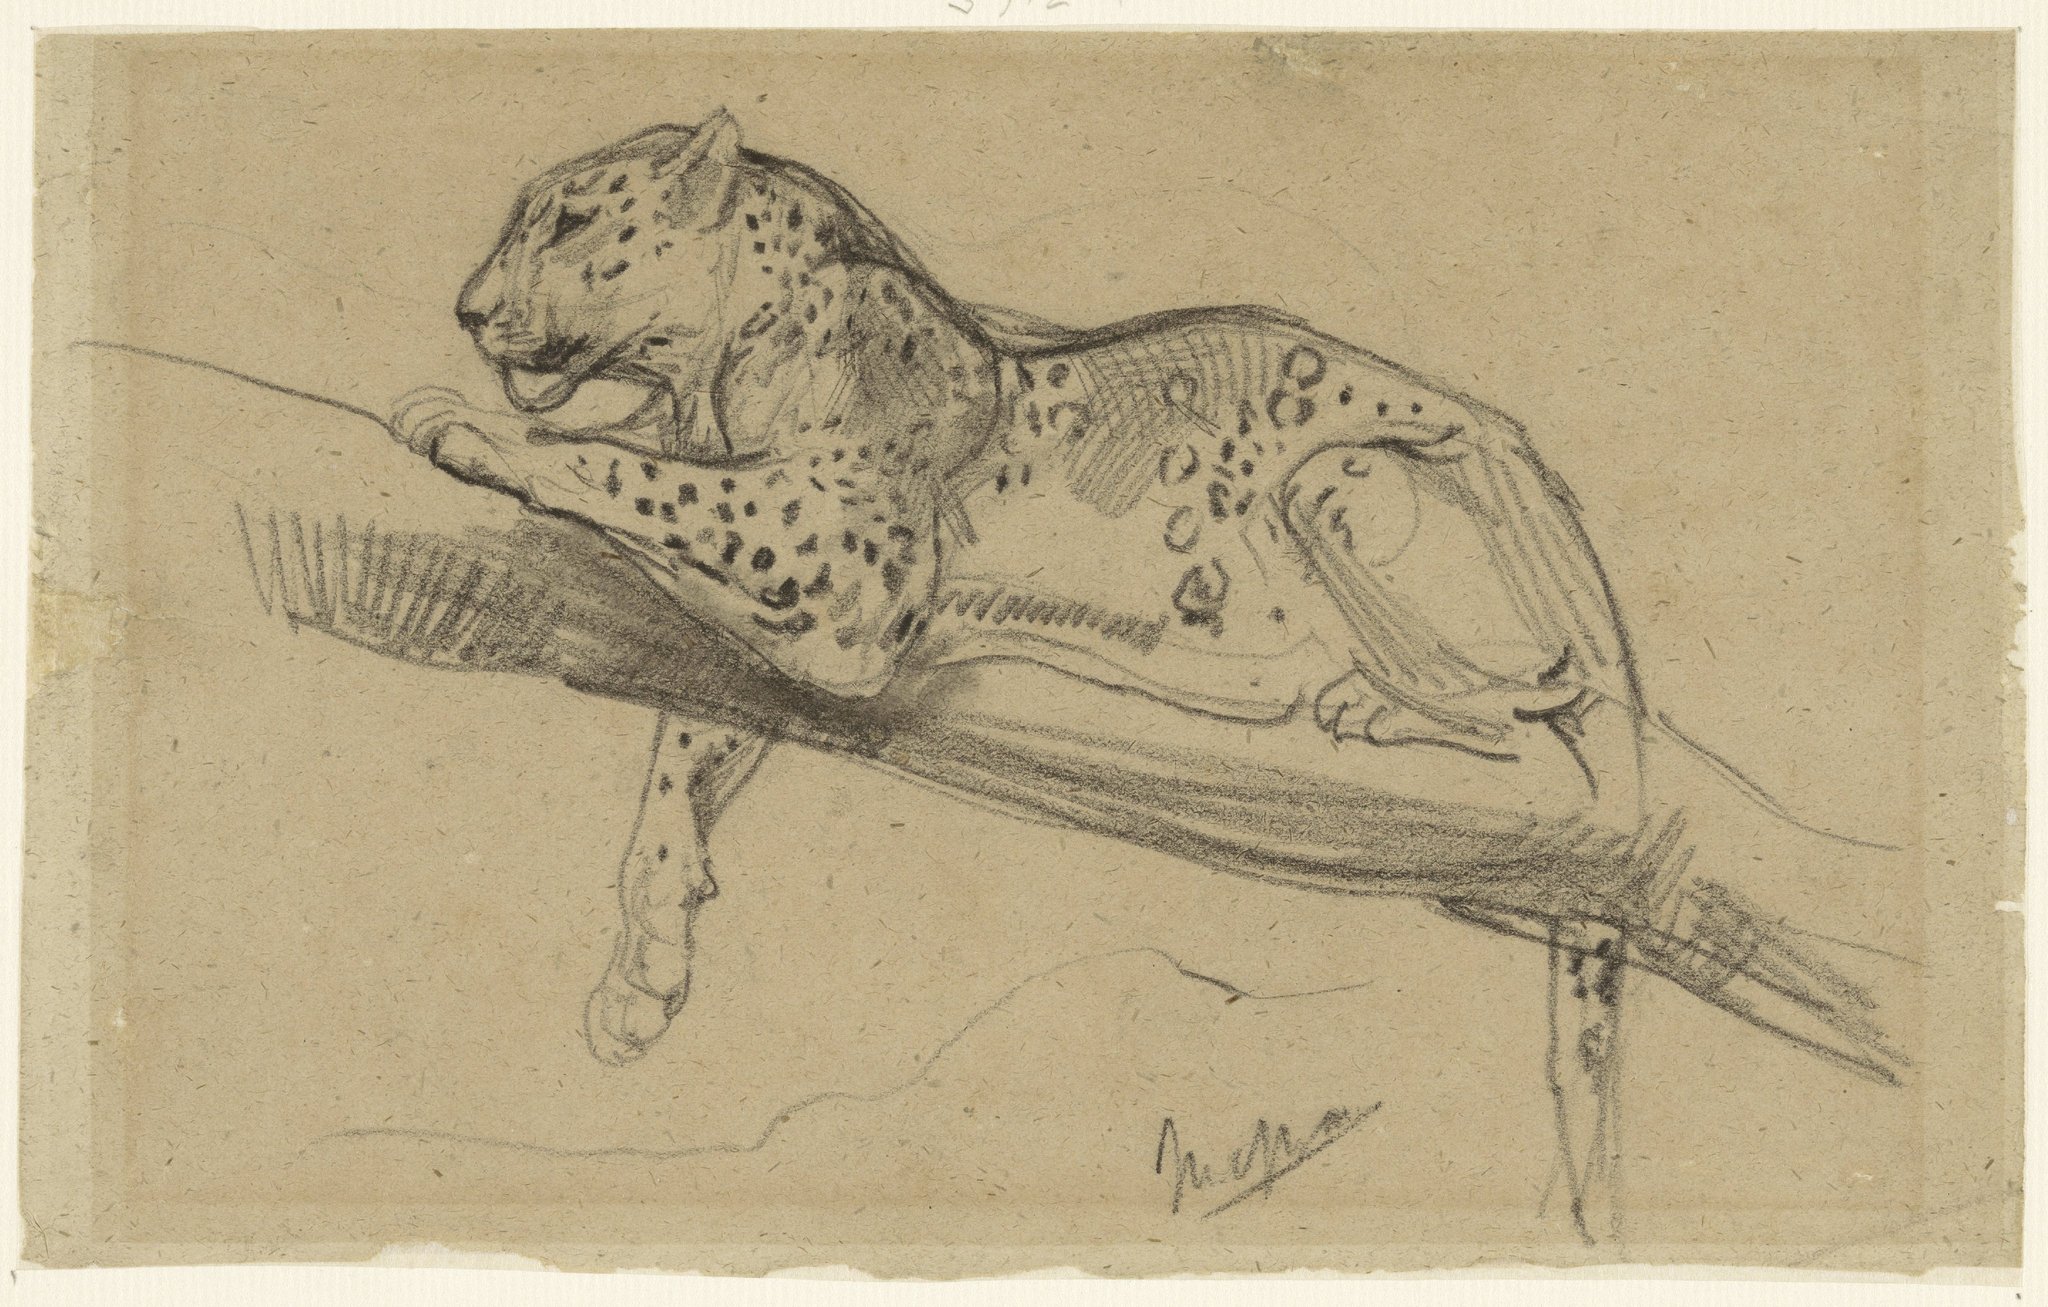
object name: drawing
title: Studie van een luipaard, liggend op een tak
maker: john macallan swan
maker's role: draughtsman, painter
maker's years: 1847-1910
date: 1857-1910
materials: chalk, paper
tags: beasts of prey, predatory animals: leopard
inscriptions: signature: ‘JM Swan’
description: Studie van een luipaard, liggend op een tak